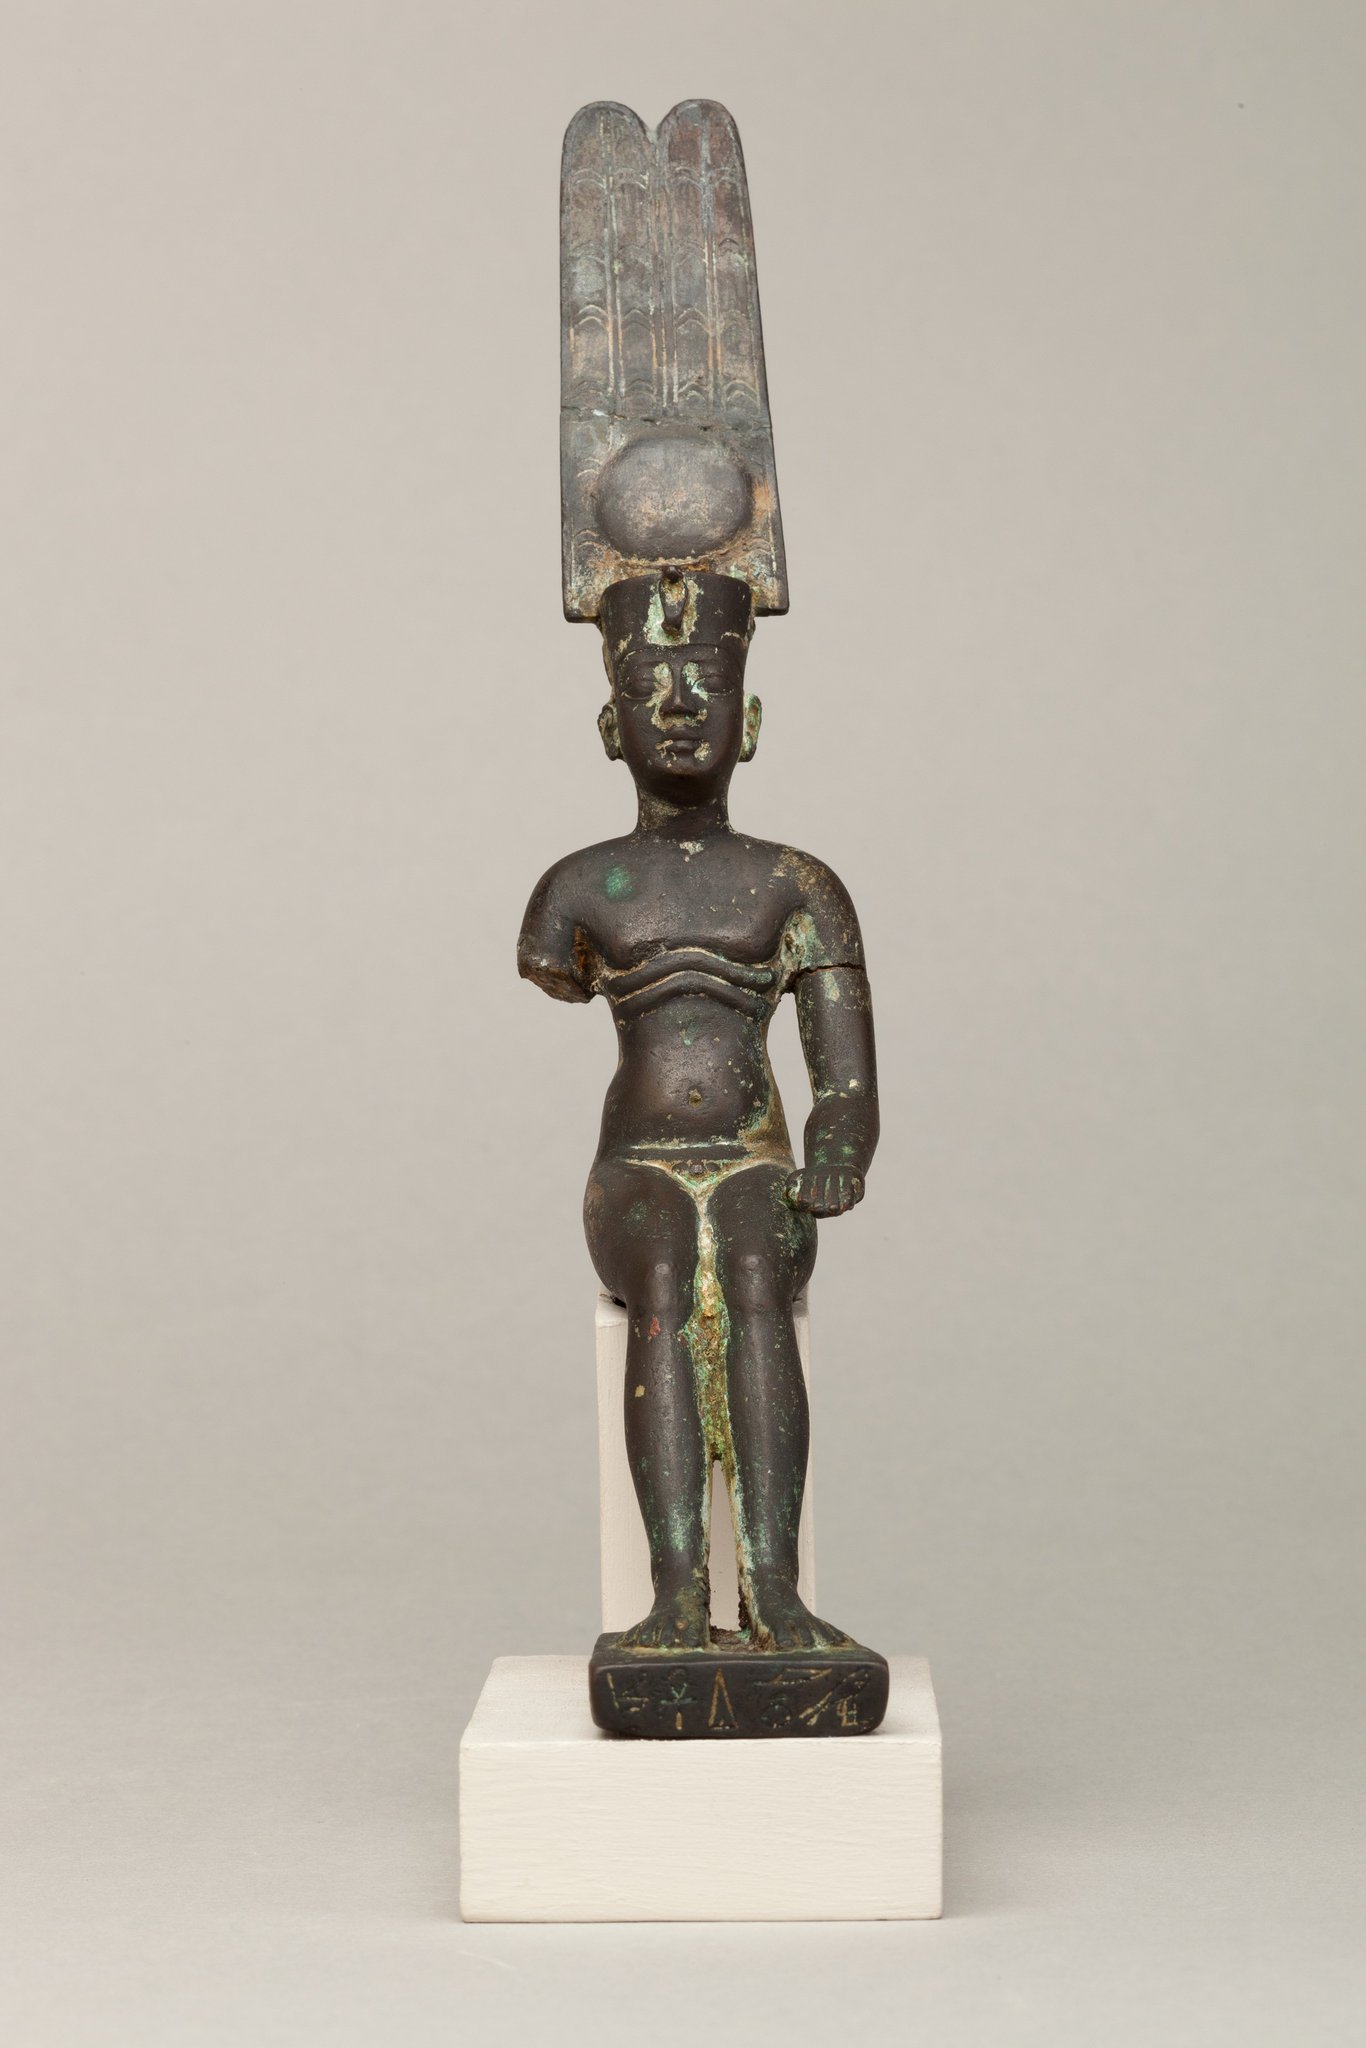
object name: statuette, child god, horus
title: Child god wearing Amonian crown and named Horus of Mednit (Aphroditopolis)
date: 664-630 BCE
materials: metal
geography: egypt